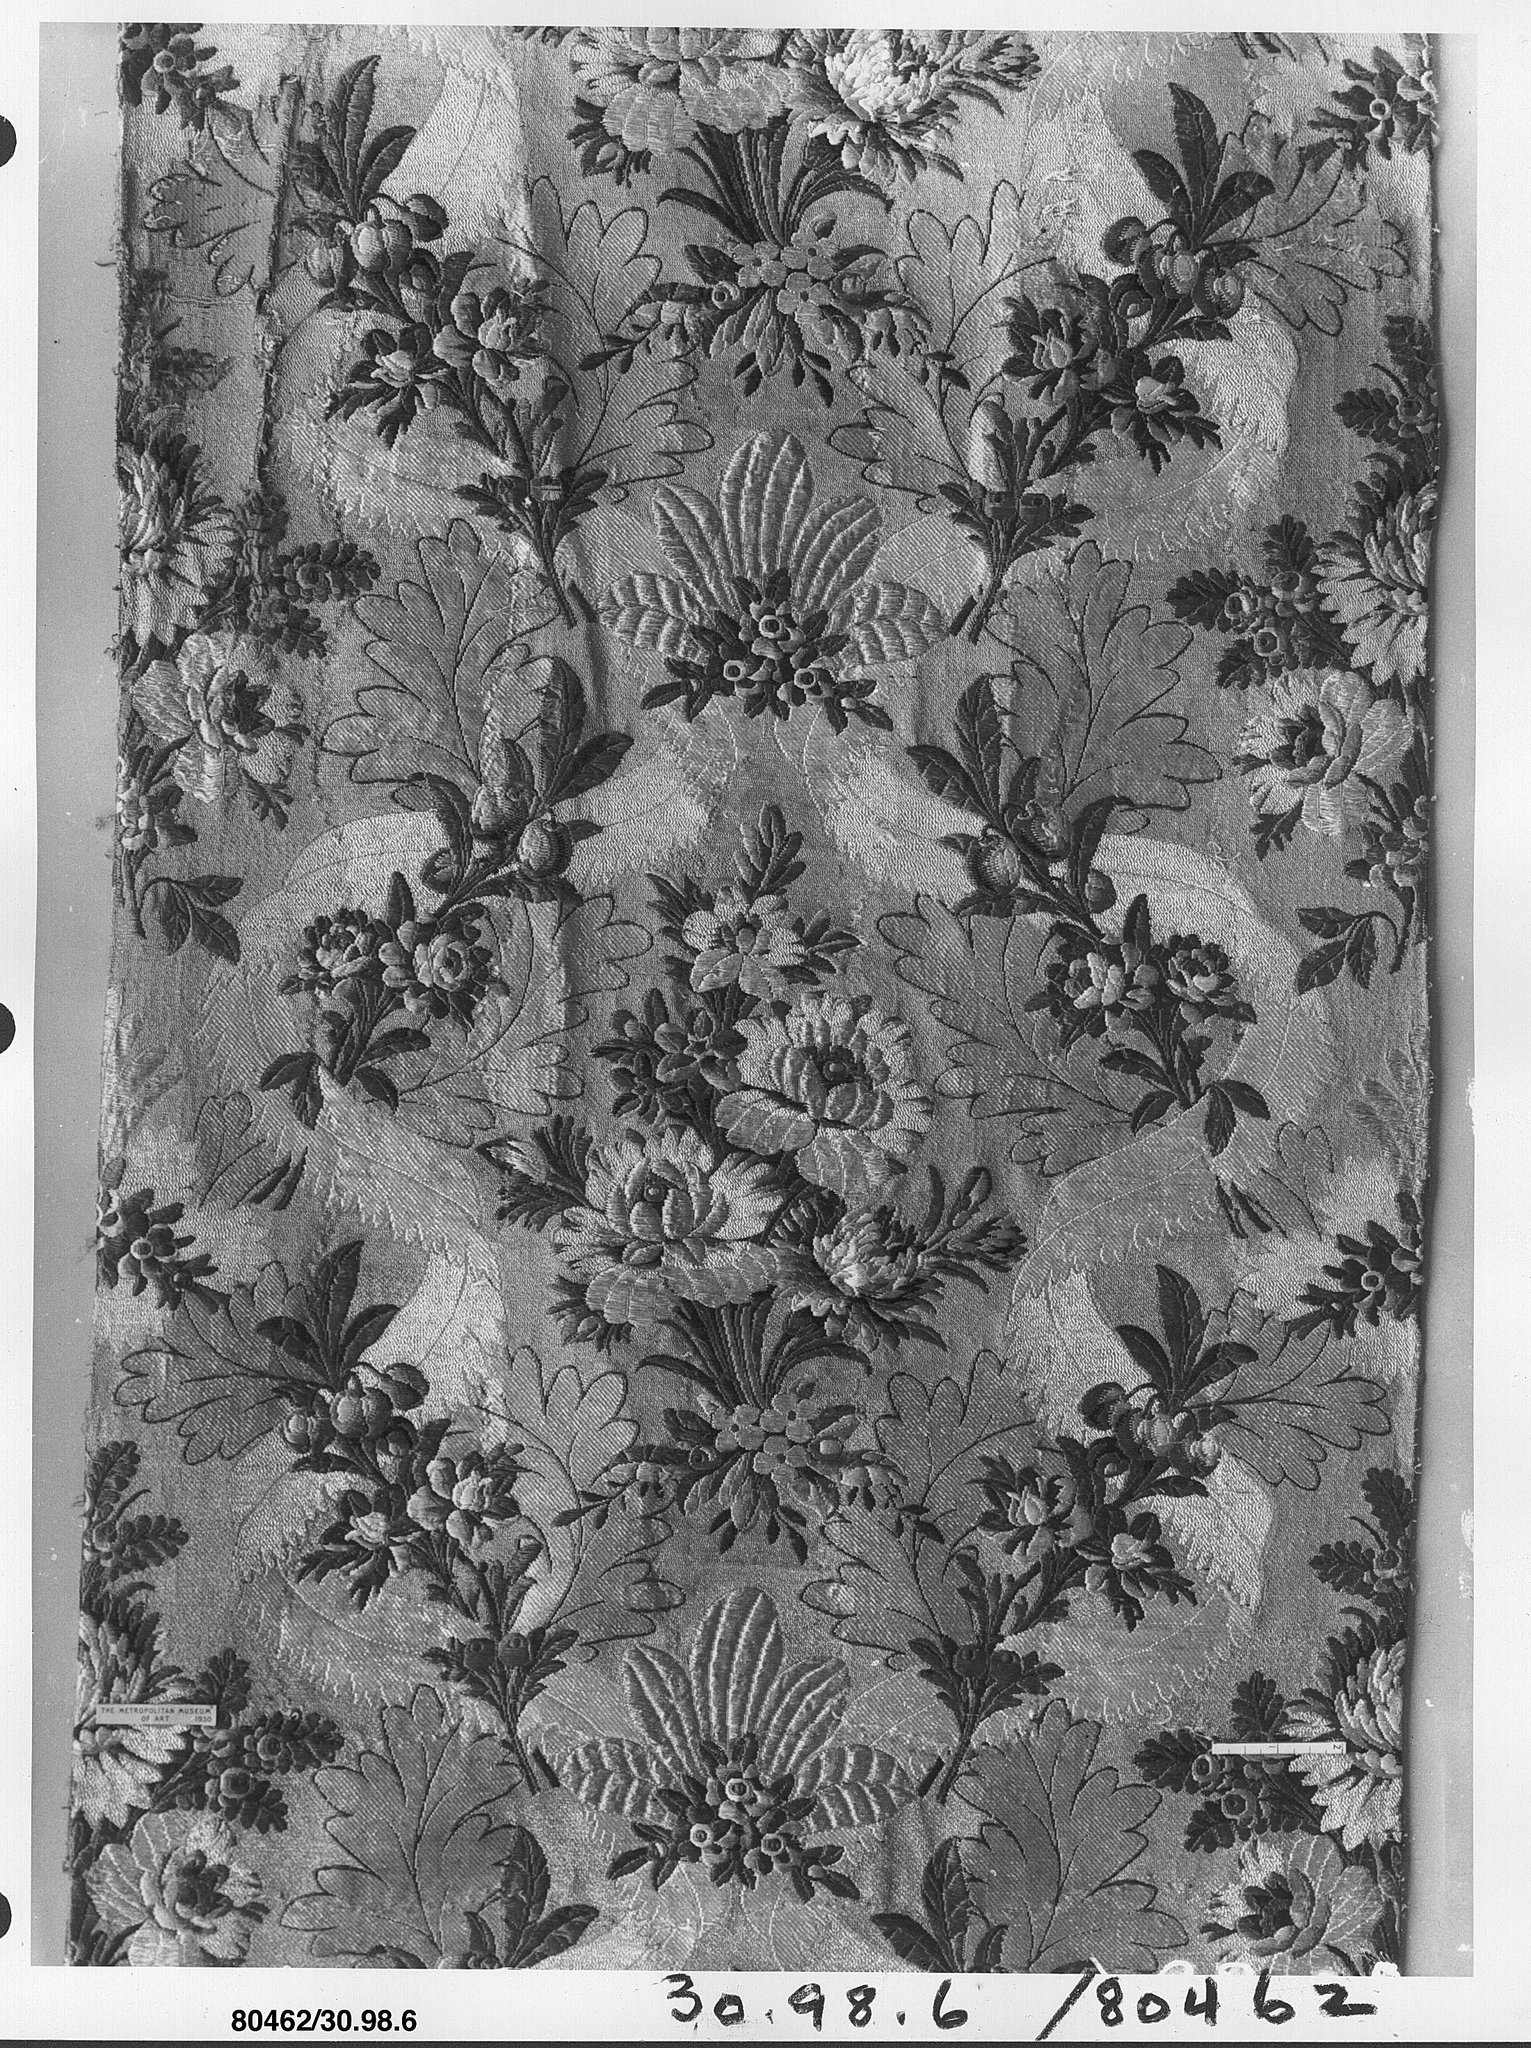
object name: piece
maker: lazareff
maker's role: manufactory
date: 1701-1800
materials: cotton, metal thread, silk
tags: flowers,leaves